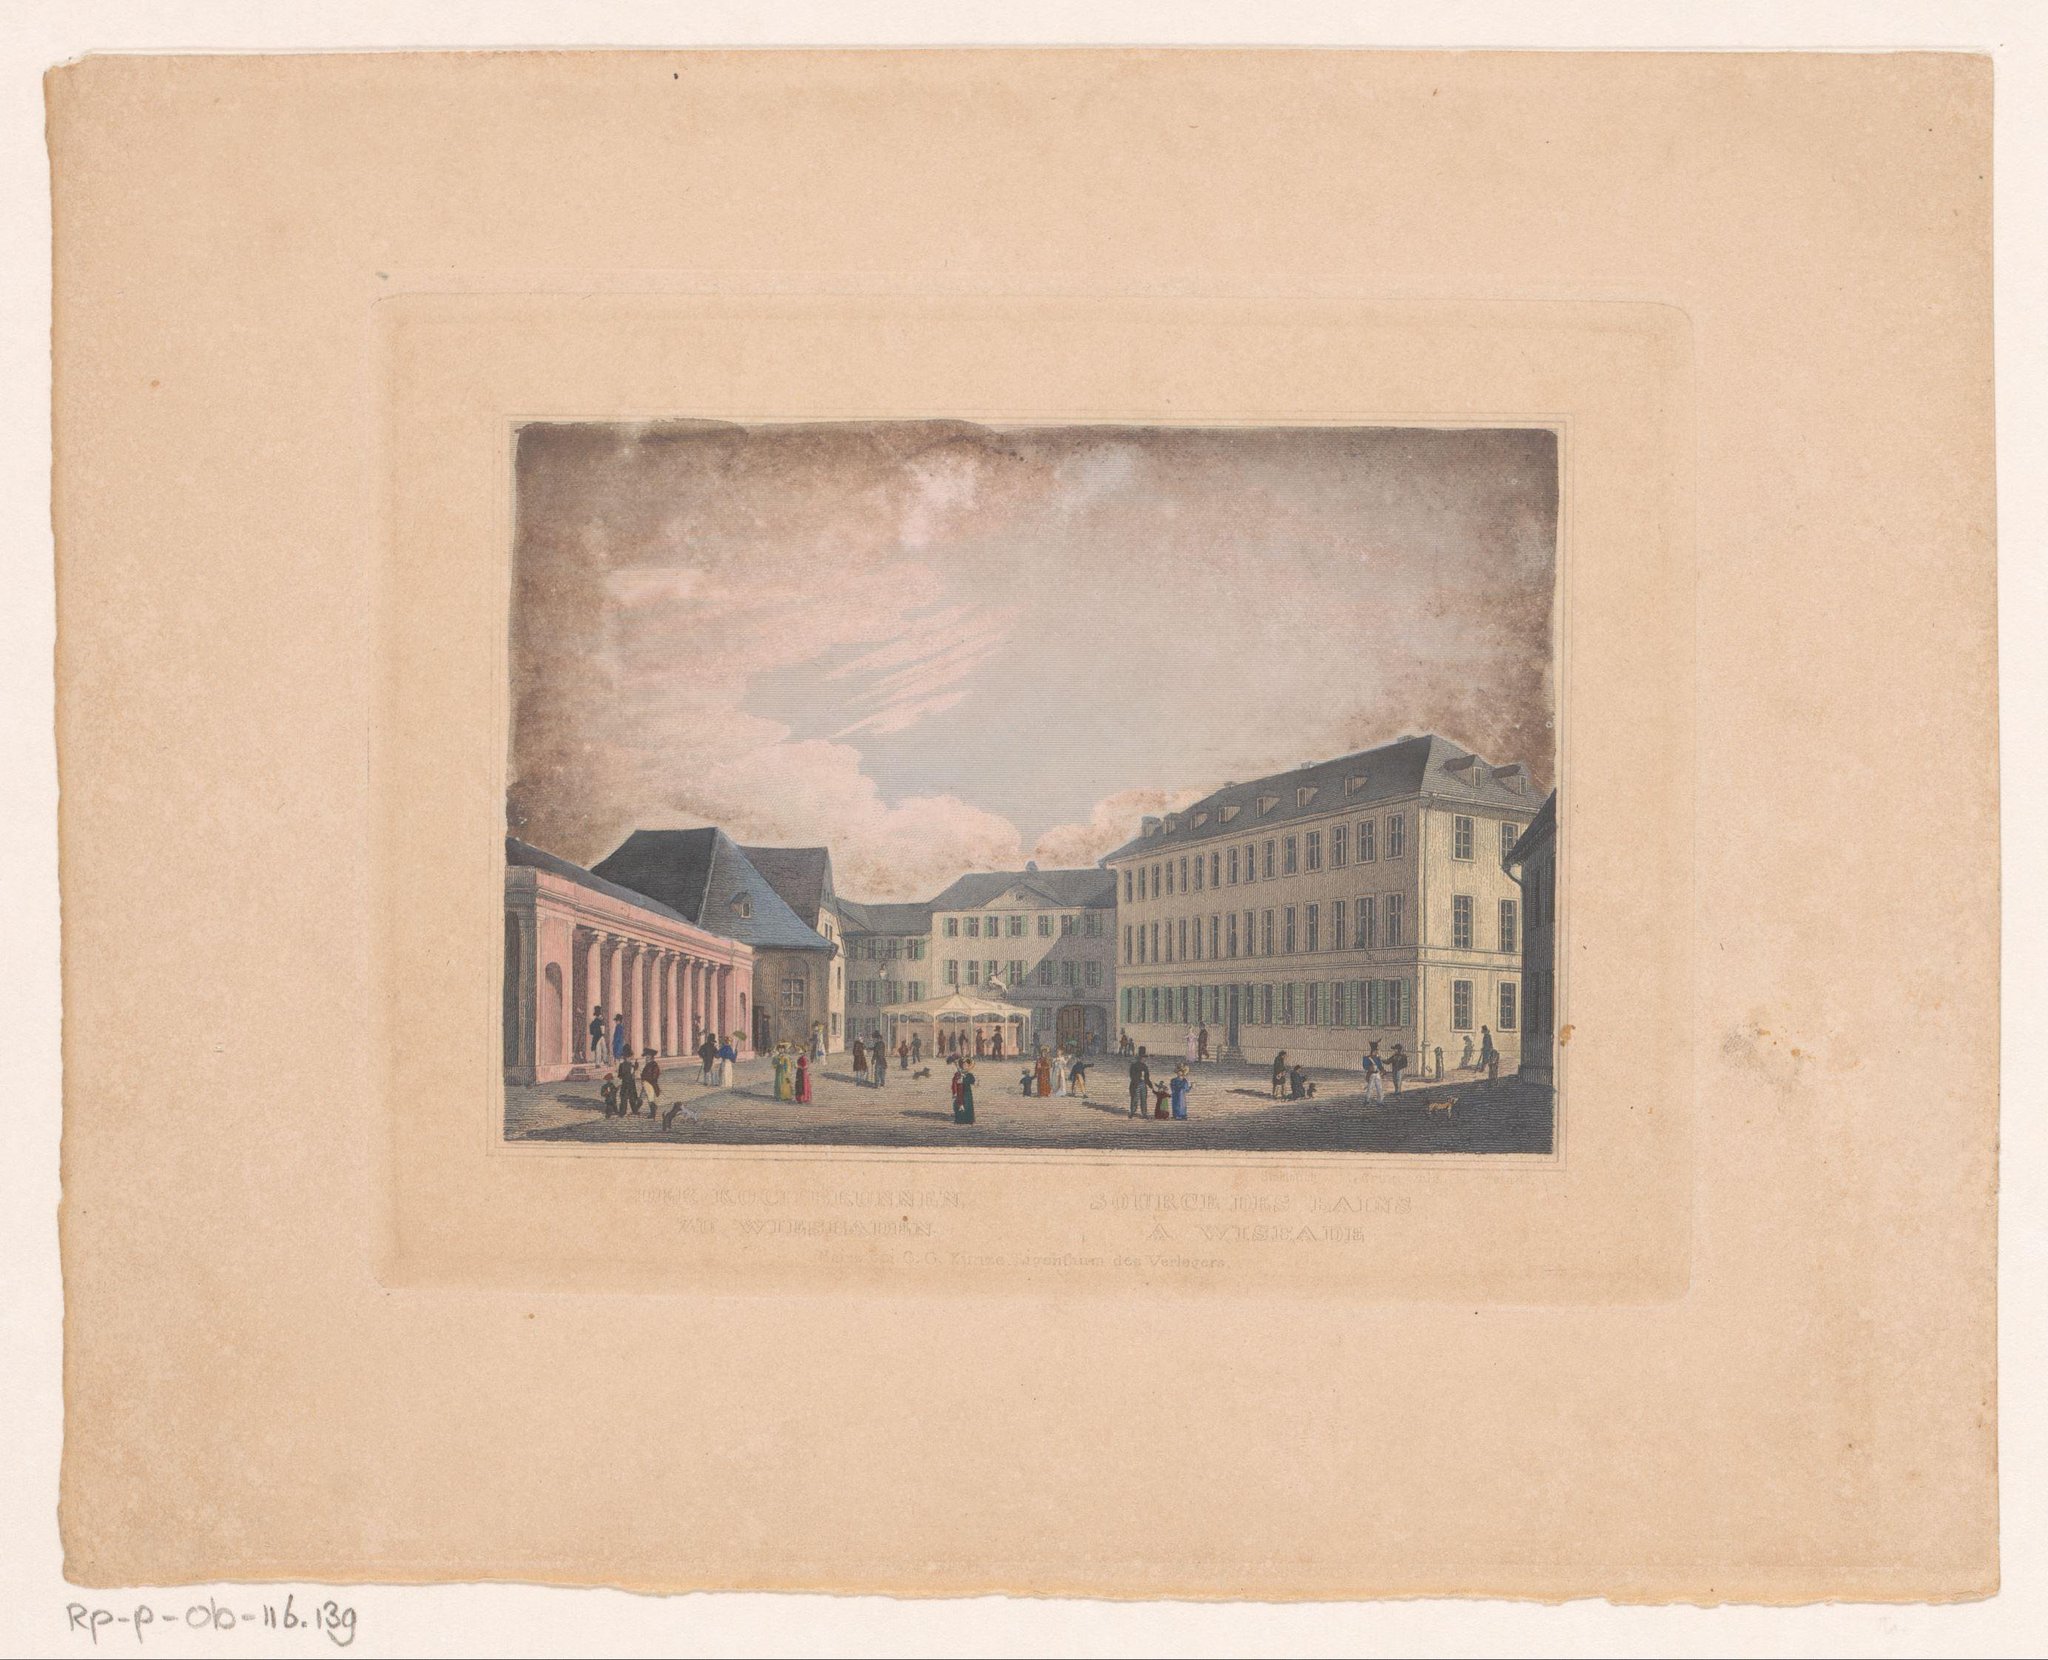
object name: print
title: Gezicht op de Kochbrunnen in Wiesbaden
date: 1811-1848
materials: paper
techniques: hand coloring, engraving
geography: darmstadt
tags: city-view in general; 'veduta', hot spring, geyser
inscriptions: collector's mark: Lugt 2228